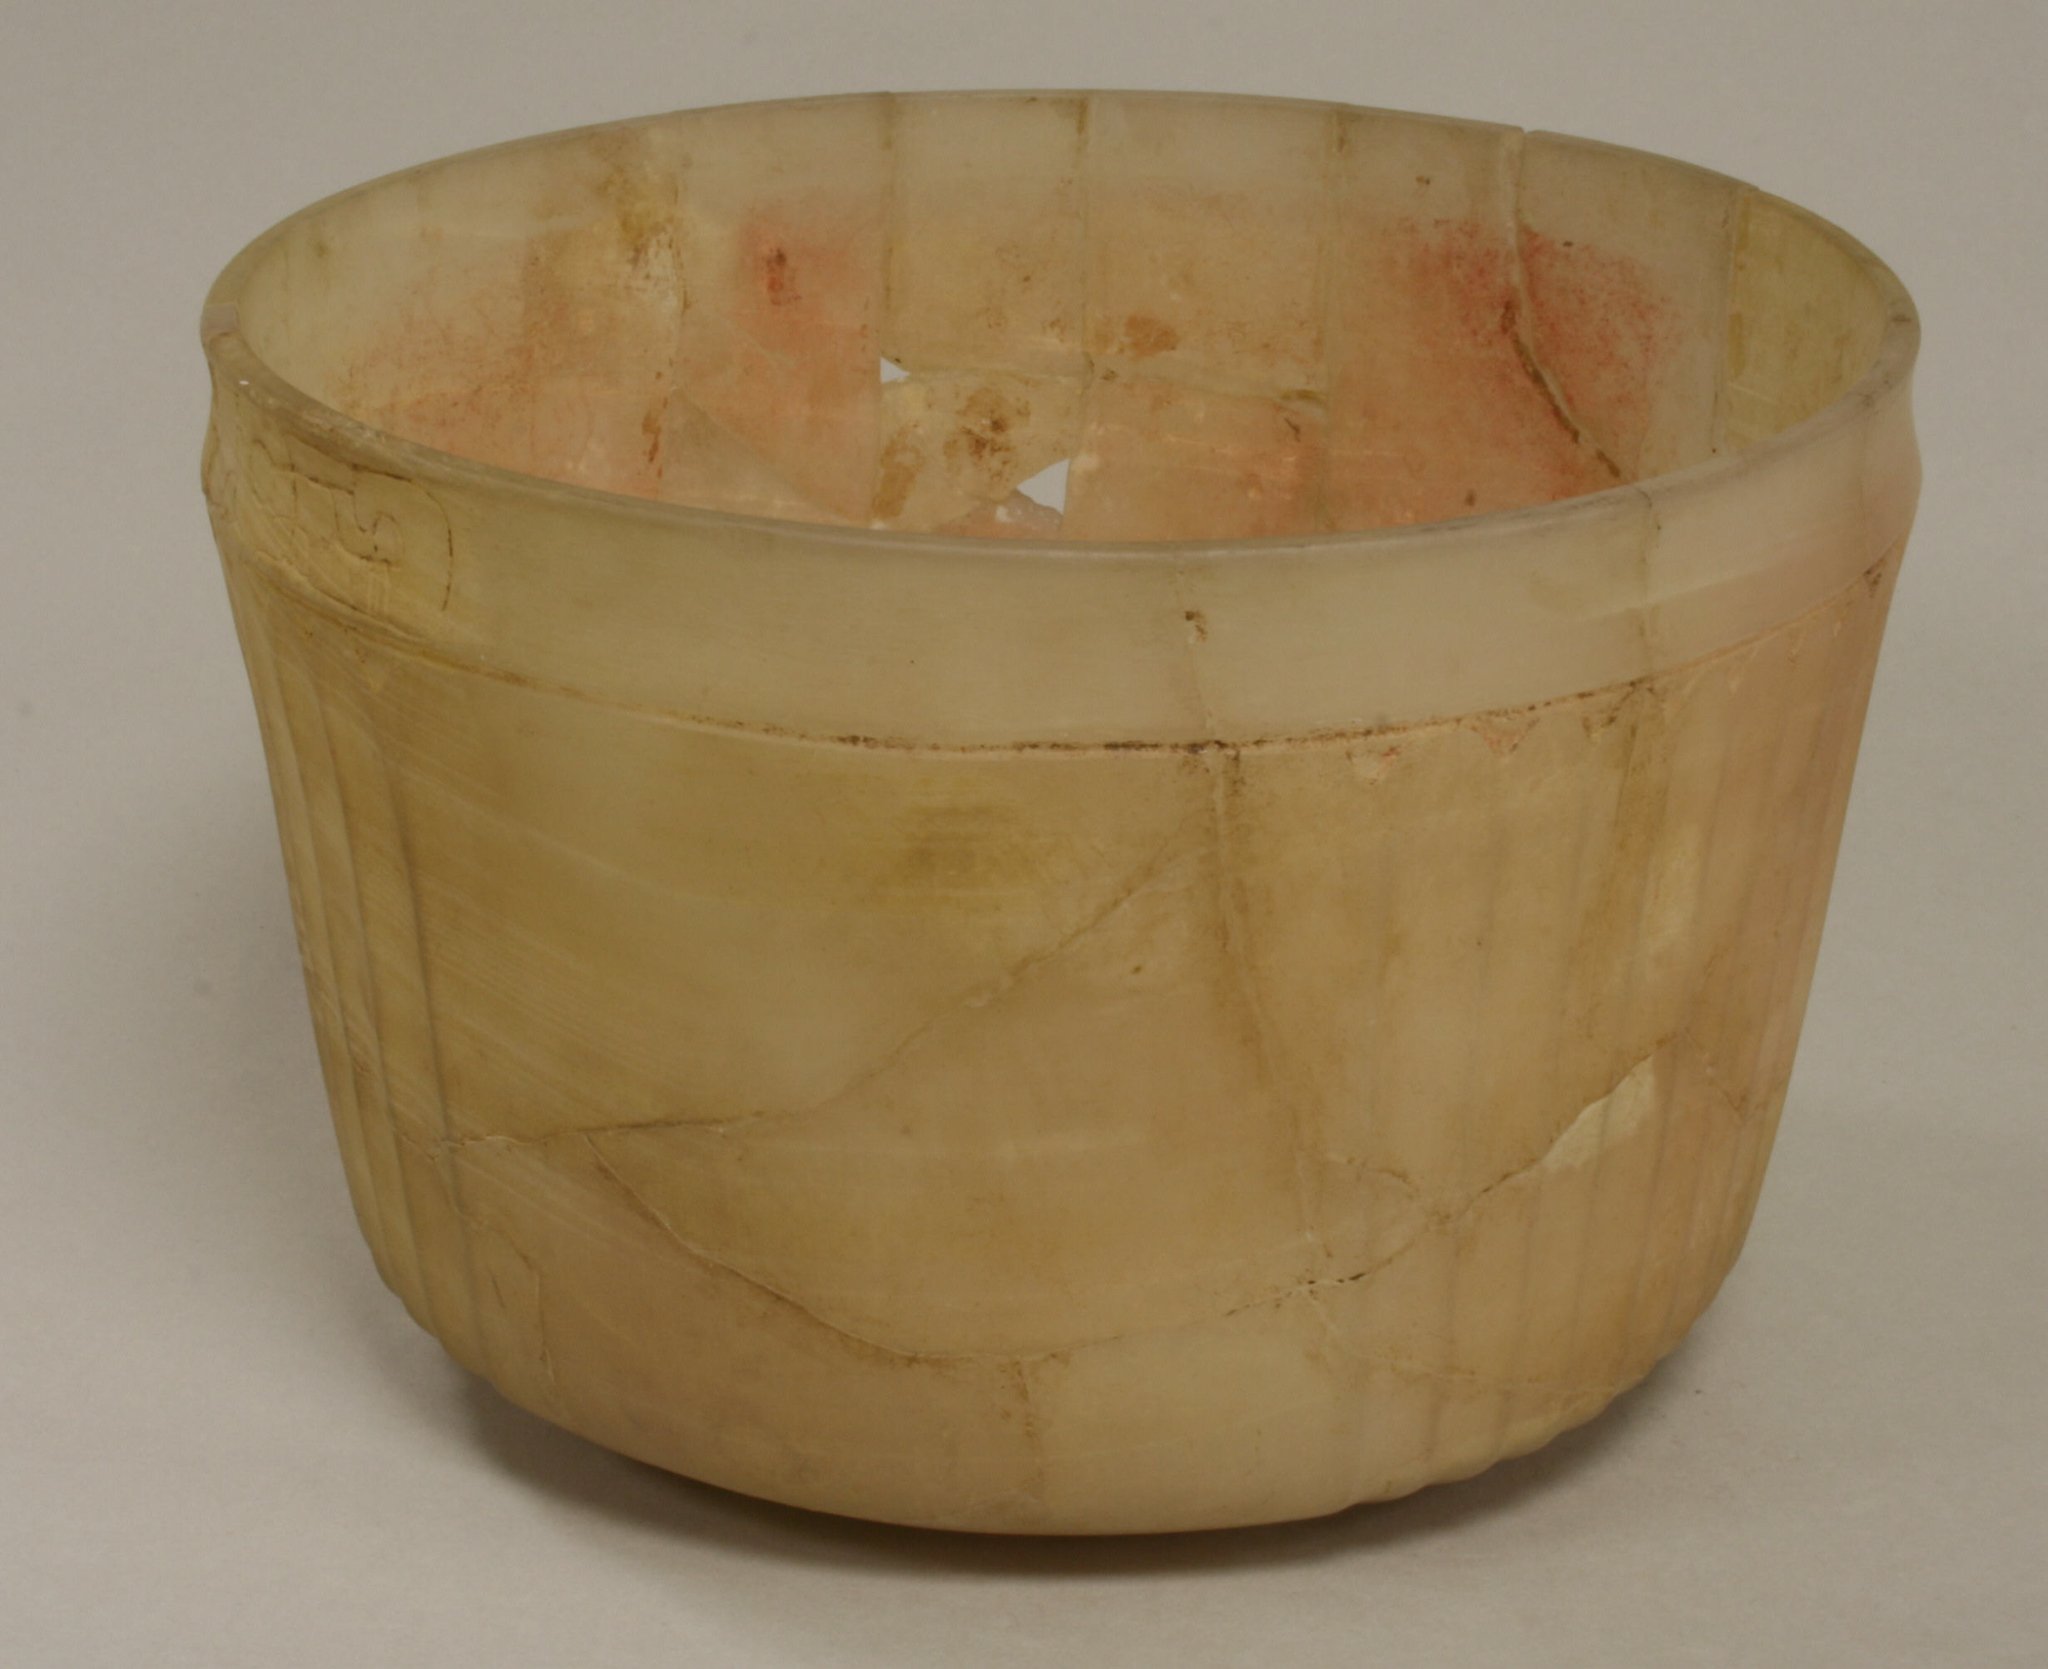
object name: bowl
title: Onyx Bowl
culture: mexican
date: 501-1000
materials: marble, onyx, pigment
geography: mexico